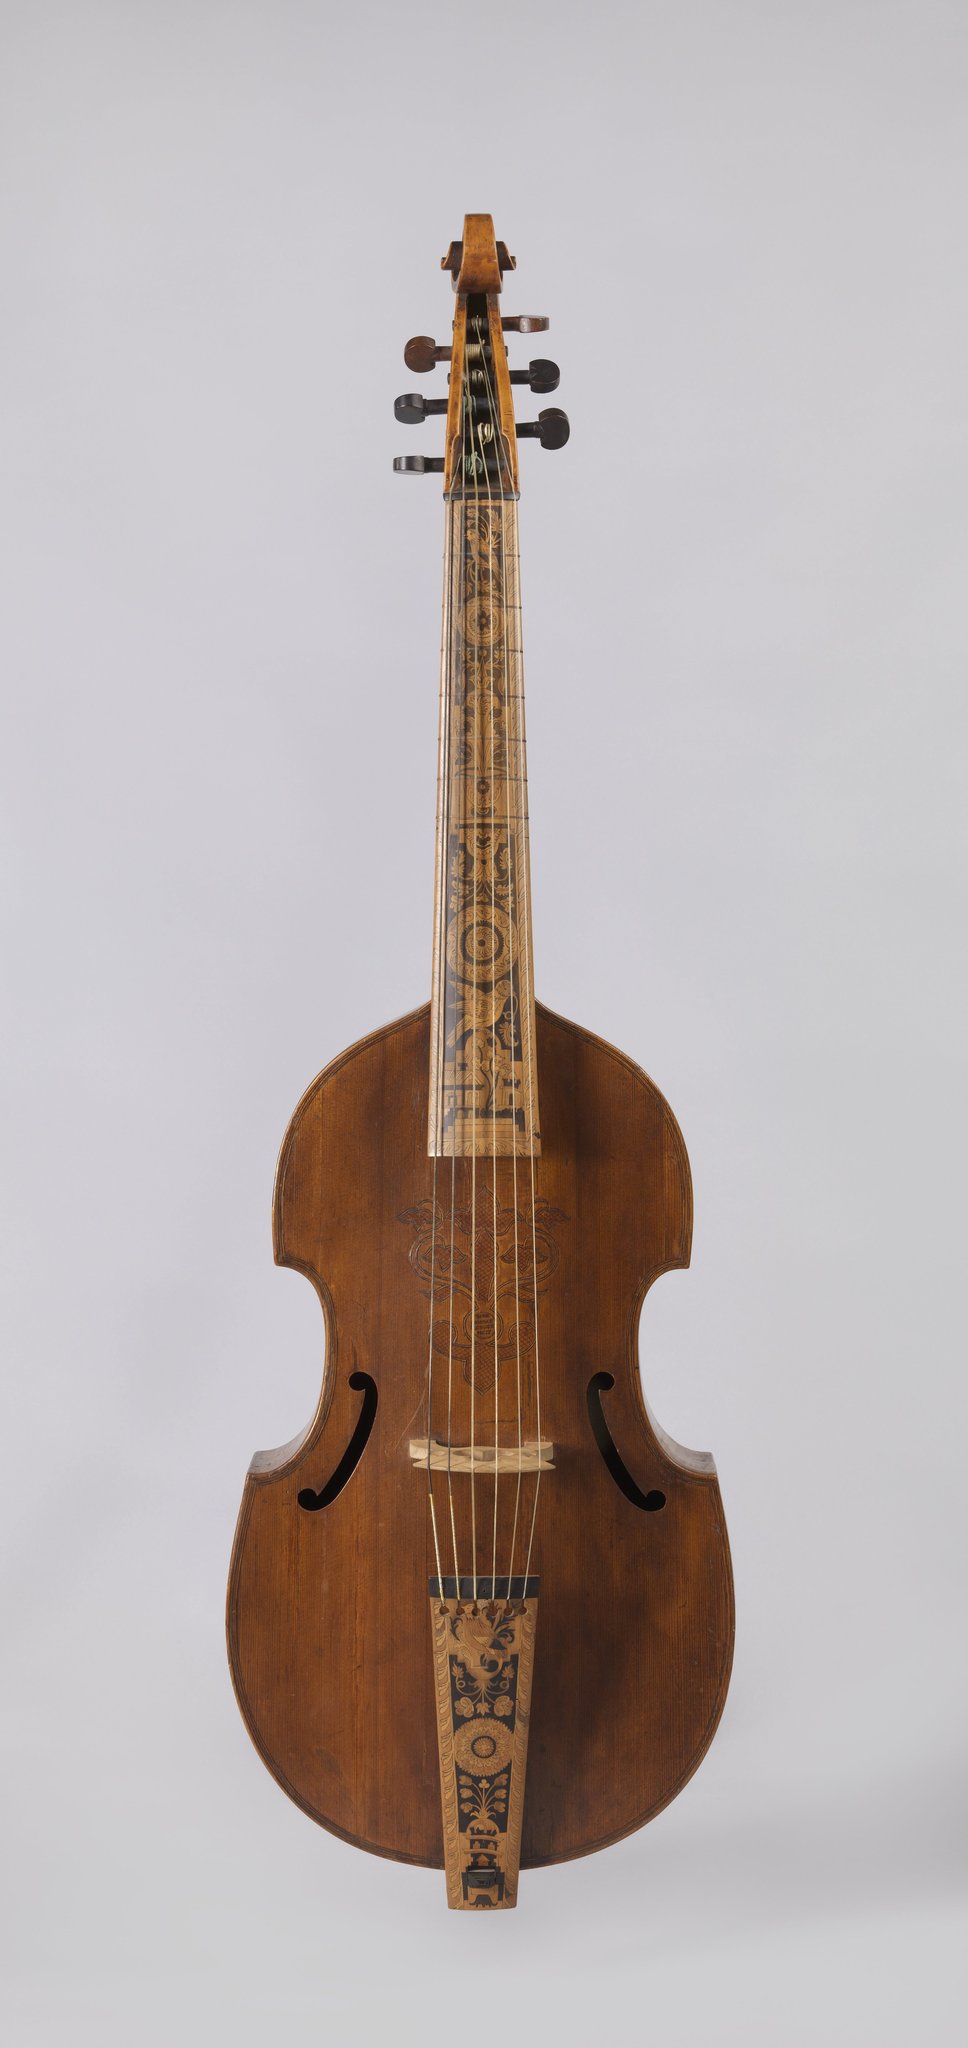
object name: musical instrument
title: Bass viol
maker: barak norman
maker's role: musical instrument maker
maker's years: 1651-1724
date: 1705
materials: wood, intestine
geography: london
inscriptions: signature: ‘Gerepareerd door // K. van der Meer // Amsterdam 1917’, signature: ‘Barak Norman // at the Bass Viol // St Pauls Alley // London fecit 1705’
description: Barak Norman’s viols have been described as made in ‘the elegant English style’. Around 1700 Norman preferred to make cellos, though bass viols continued to be made. The viol has frets, while the cello does not have this facility. The viol also has more strings. Inside, the viol is related to lute building traditions, the cello belongs to the tradition of violin building.